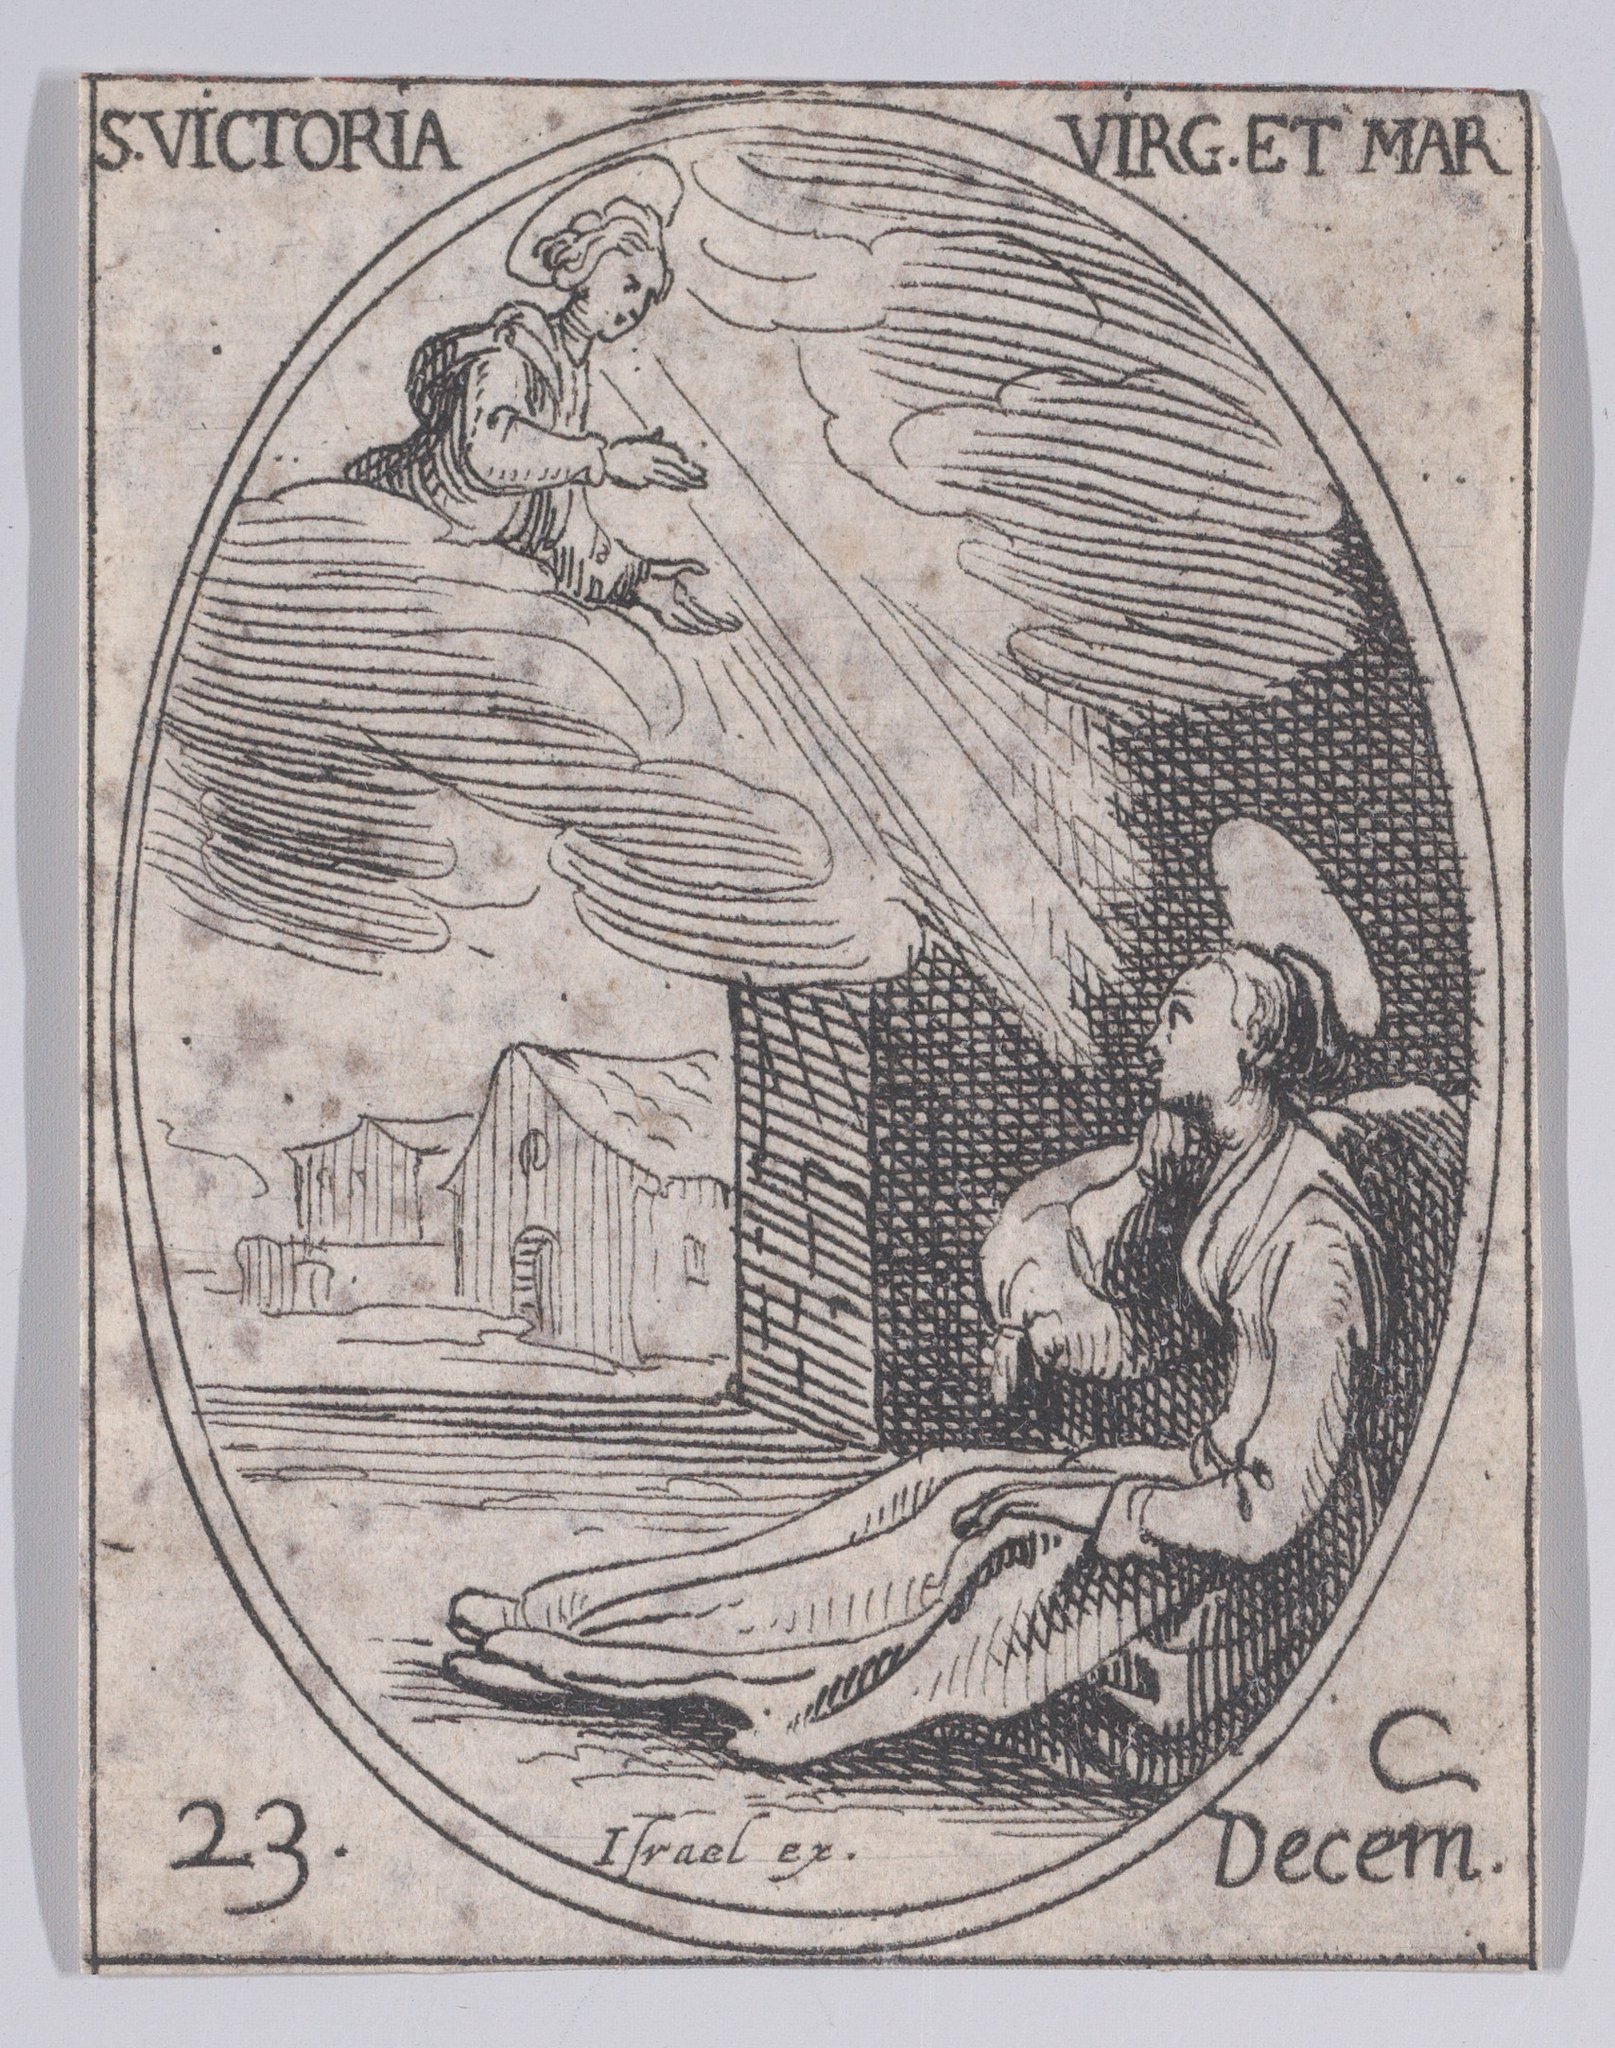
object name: print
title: Ste. Victoire, vierge et martyre (St. Victoria, Virgin and Martyr), December 23rd, from "Les Images De Tous Les Saincts et Saintes de L'Année" (Images of All of the Saints and Religious Events of the Year)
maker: jacques callot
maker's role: artist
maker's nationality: french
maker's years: 1592-1635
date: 1636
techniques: etching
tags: women,saints